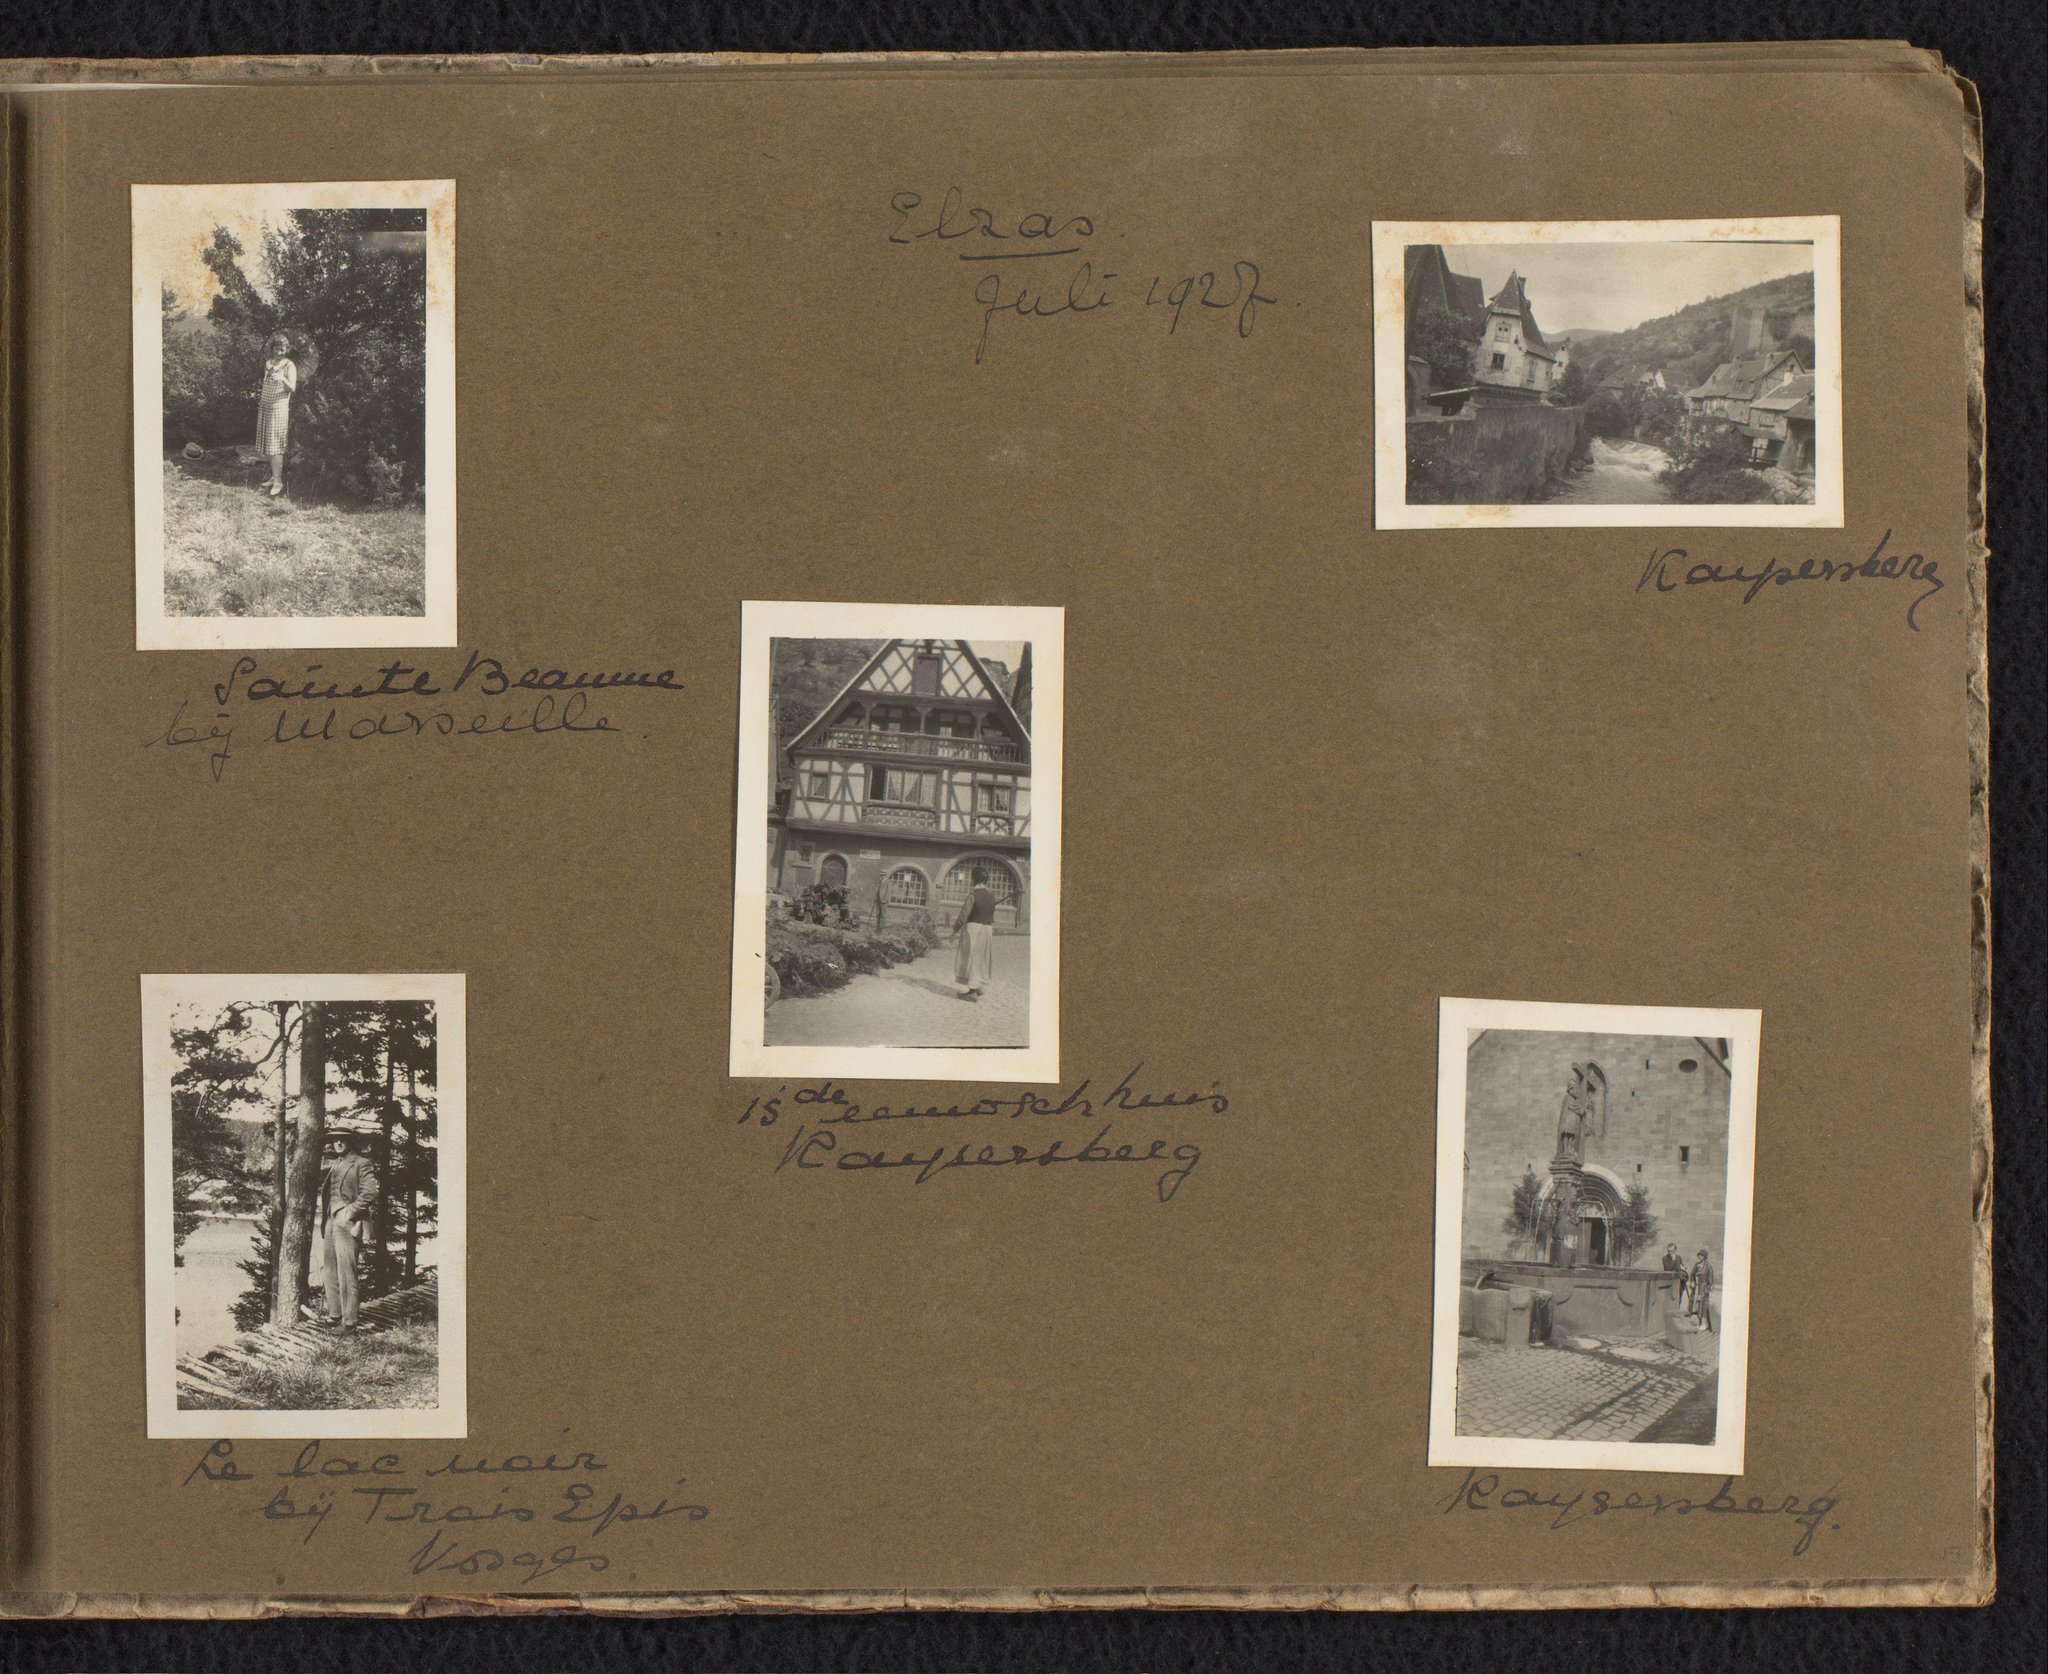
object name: album leaf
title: Vijf foto's van een reis naar de Elzas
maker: carolina frederika onnen (lien/loen)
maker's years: 1896-1983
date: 1907-1927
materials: paper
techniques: gelatin silver print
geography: alsace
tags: village, forest, wood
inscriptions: inscription: ‘Sainte Beaume/ bij Marseille’, inscription: ‘Kaysersberg’, inscription: ‘Kaysersberg’, inscription: ‘15de eeuwsch huis/ Kaysersberg’, inscription: ‘Le lac noir/ bij Trois Epis/ Vosges’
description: Deze foto's maken deel uit van een album.